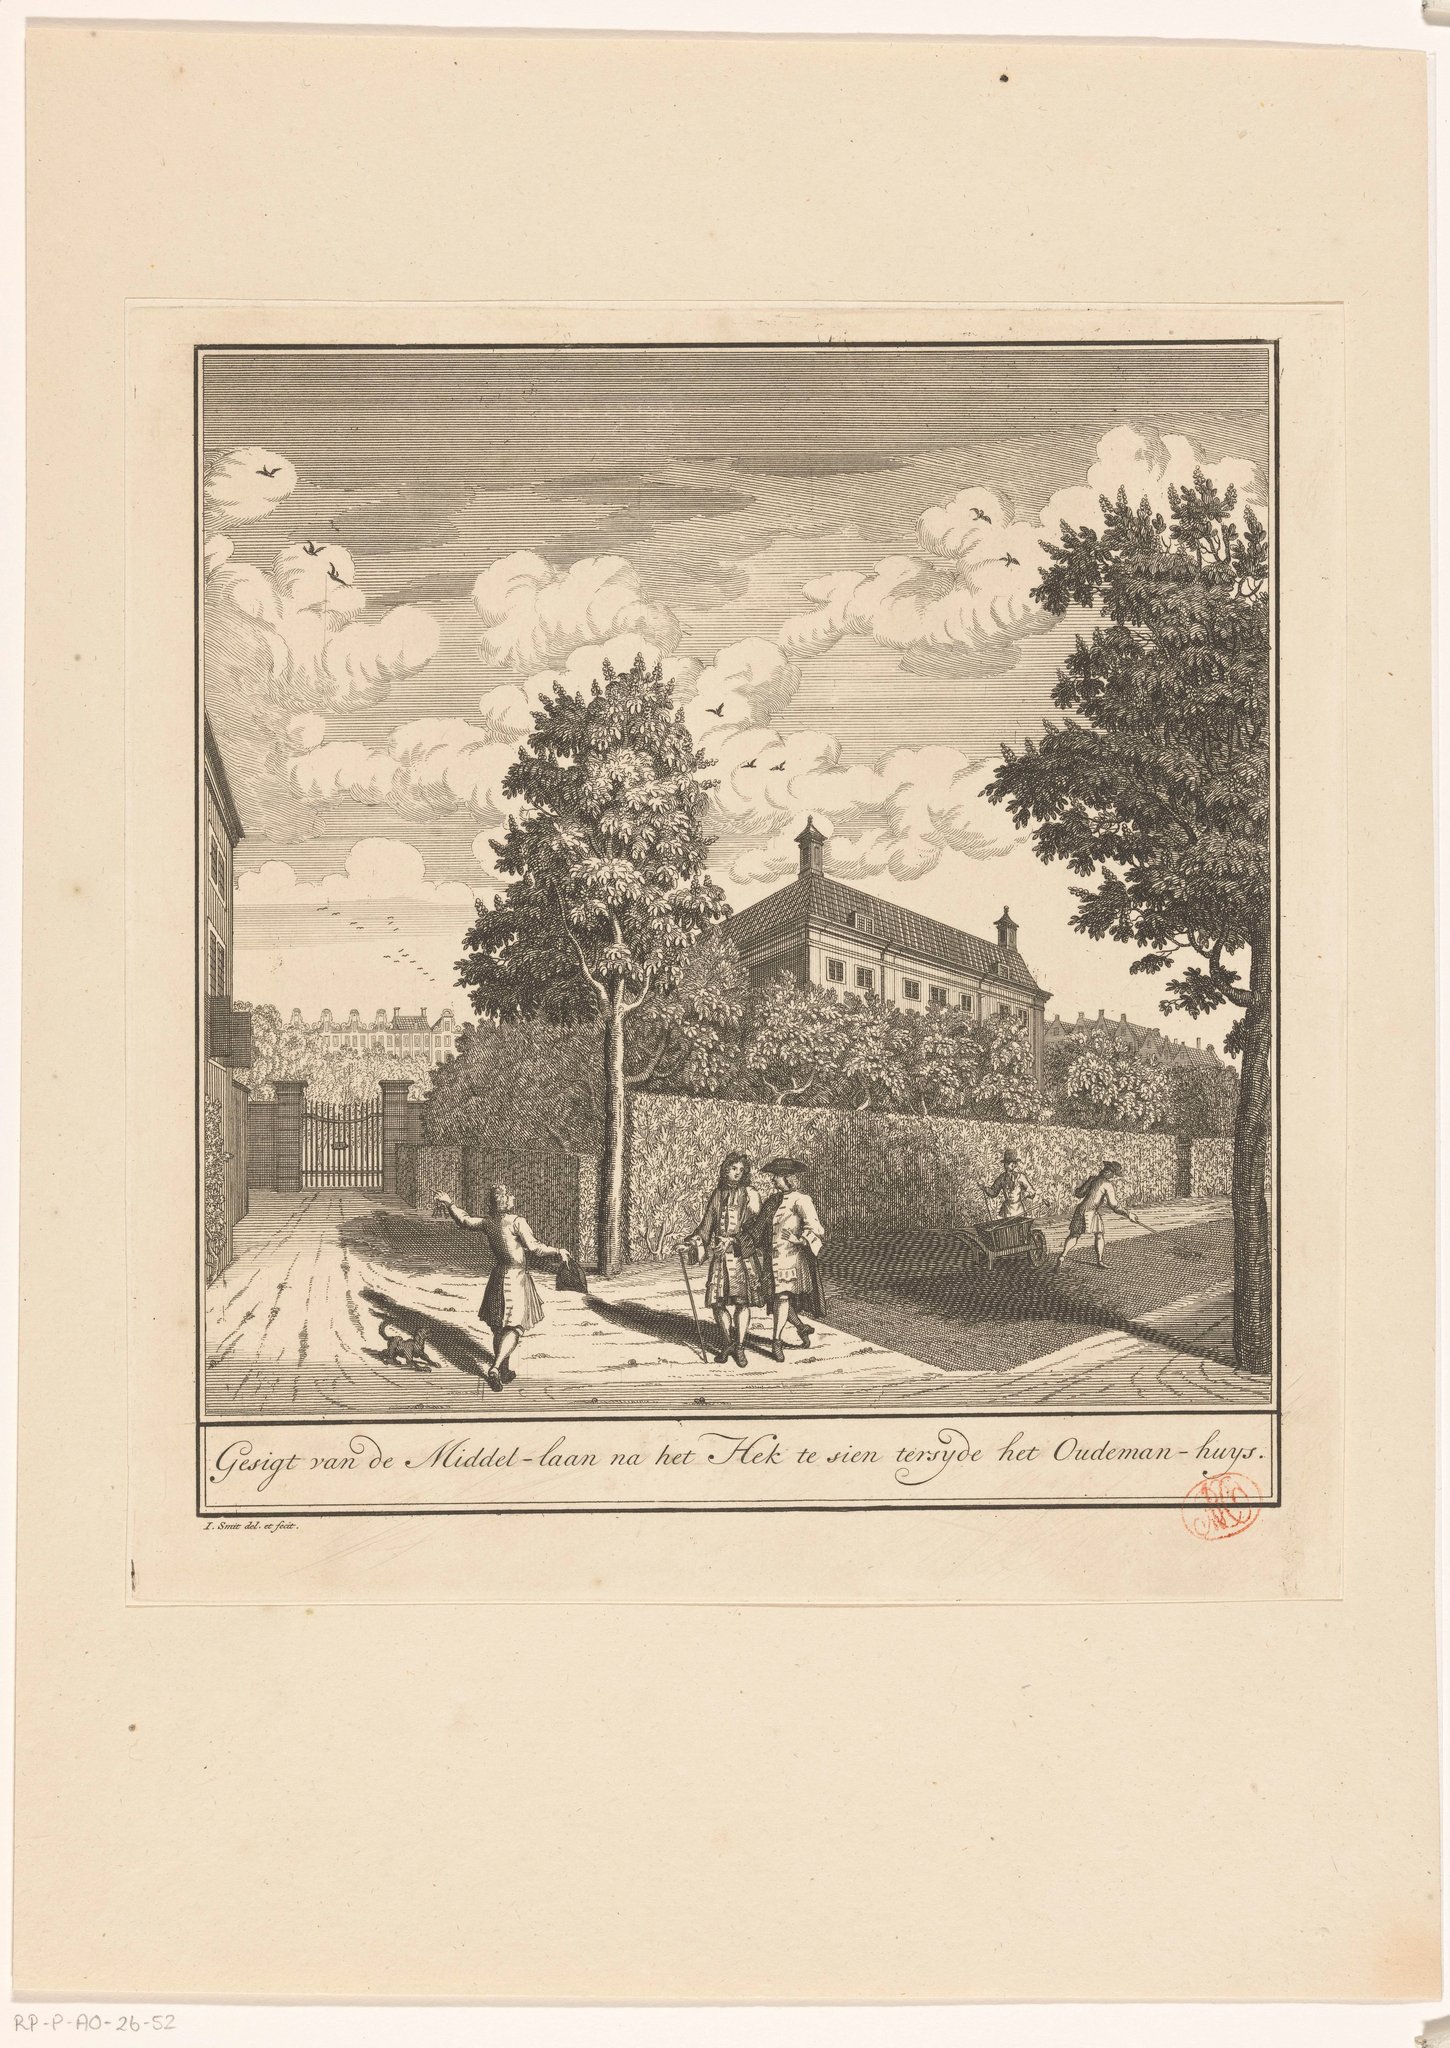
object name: print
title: Het Corvershof te Amsterdam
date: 1723-1748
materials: paper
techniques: engraving, etching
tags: alms-house (dutch: 'hofje'), public welfare, key, french or architectonic garden; formal garden, gate, entrance, gardening, dog, old-people's home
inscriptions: collector's mark: Lugt 195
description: Gezicht op de achterkant en een deel van de tuin van het Corvershof aan de Nieuwe Herengracht te Amsterdam. Links op de achtergrond het hek naast het Diaconie Oude Vrouwen- en Mannenhuis aan de Nieuwe Herengracht. Op de voorgrond staat en man met een sleutelbos in zijn hand. Links van hem een hondje, rechts van hem twee wandelende mannen. In het midden van de laan rechts zijn twee tuinmannen aan het werk. Onderdeel van een serie prenten van het in 1723 in gebruik genomen Corvershof, bestemd voor oudere echtparen van Nederduits Gereformeerde (later Hervormde) huize.